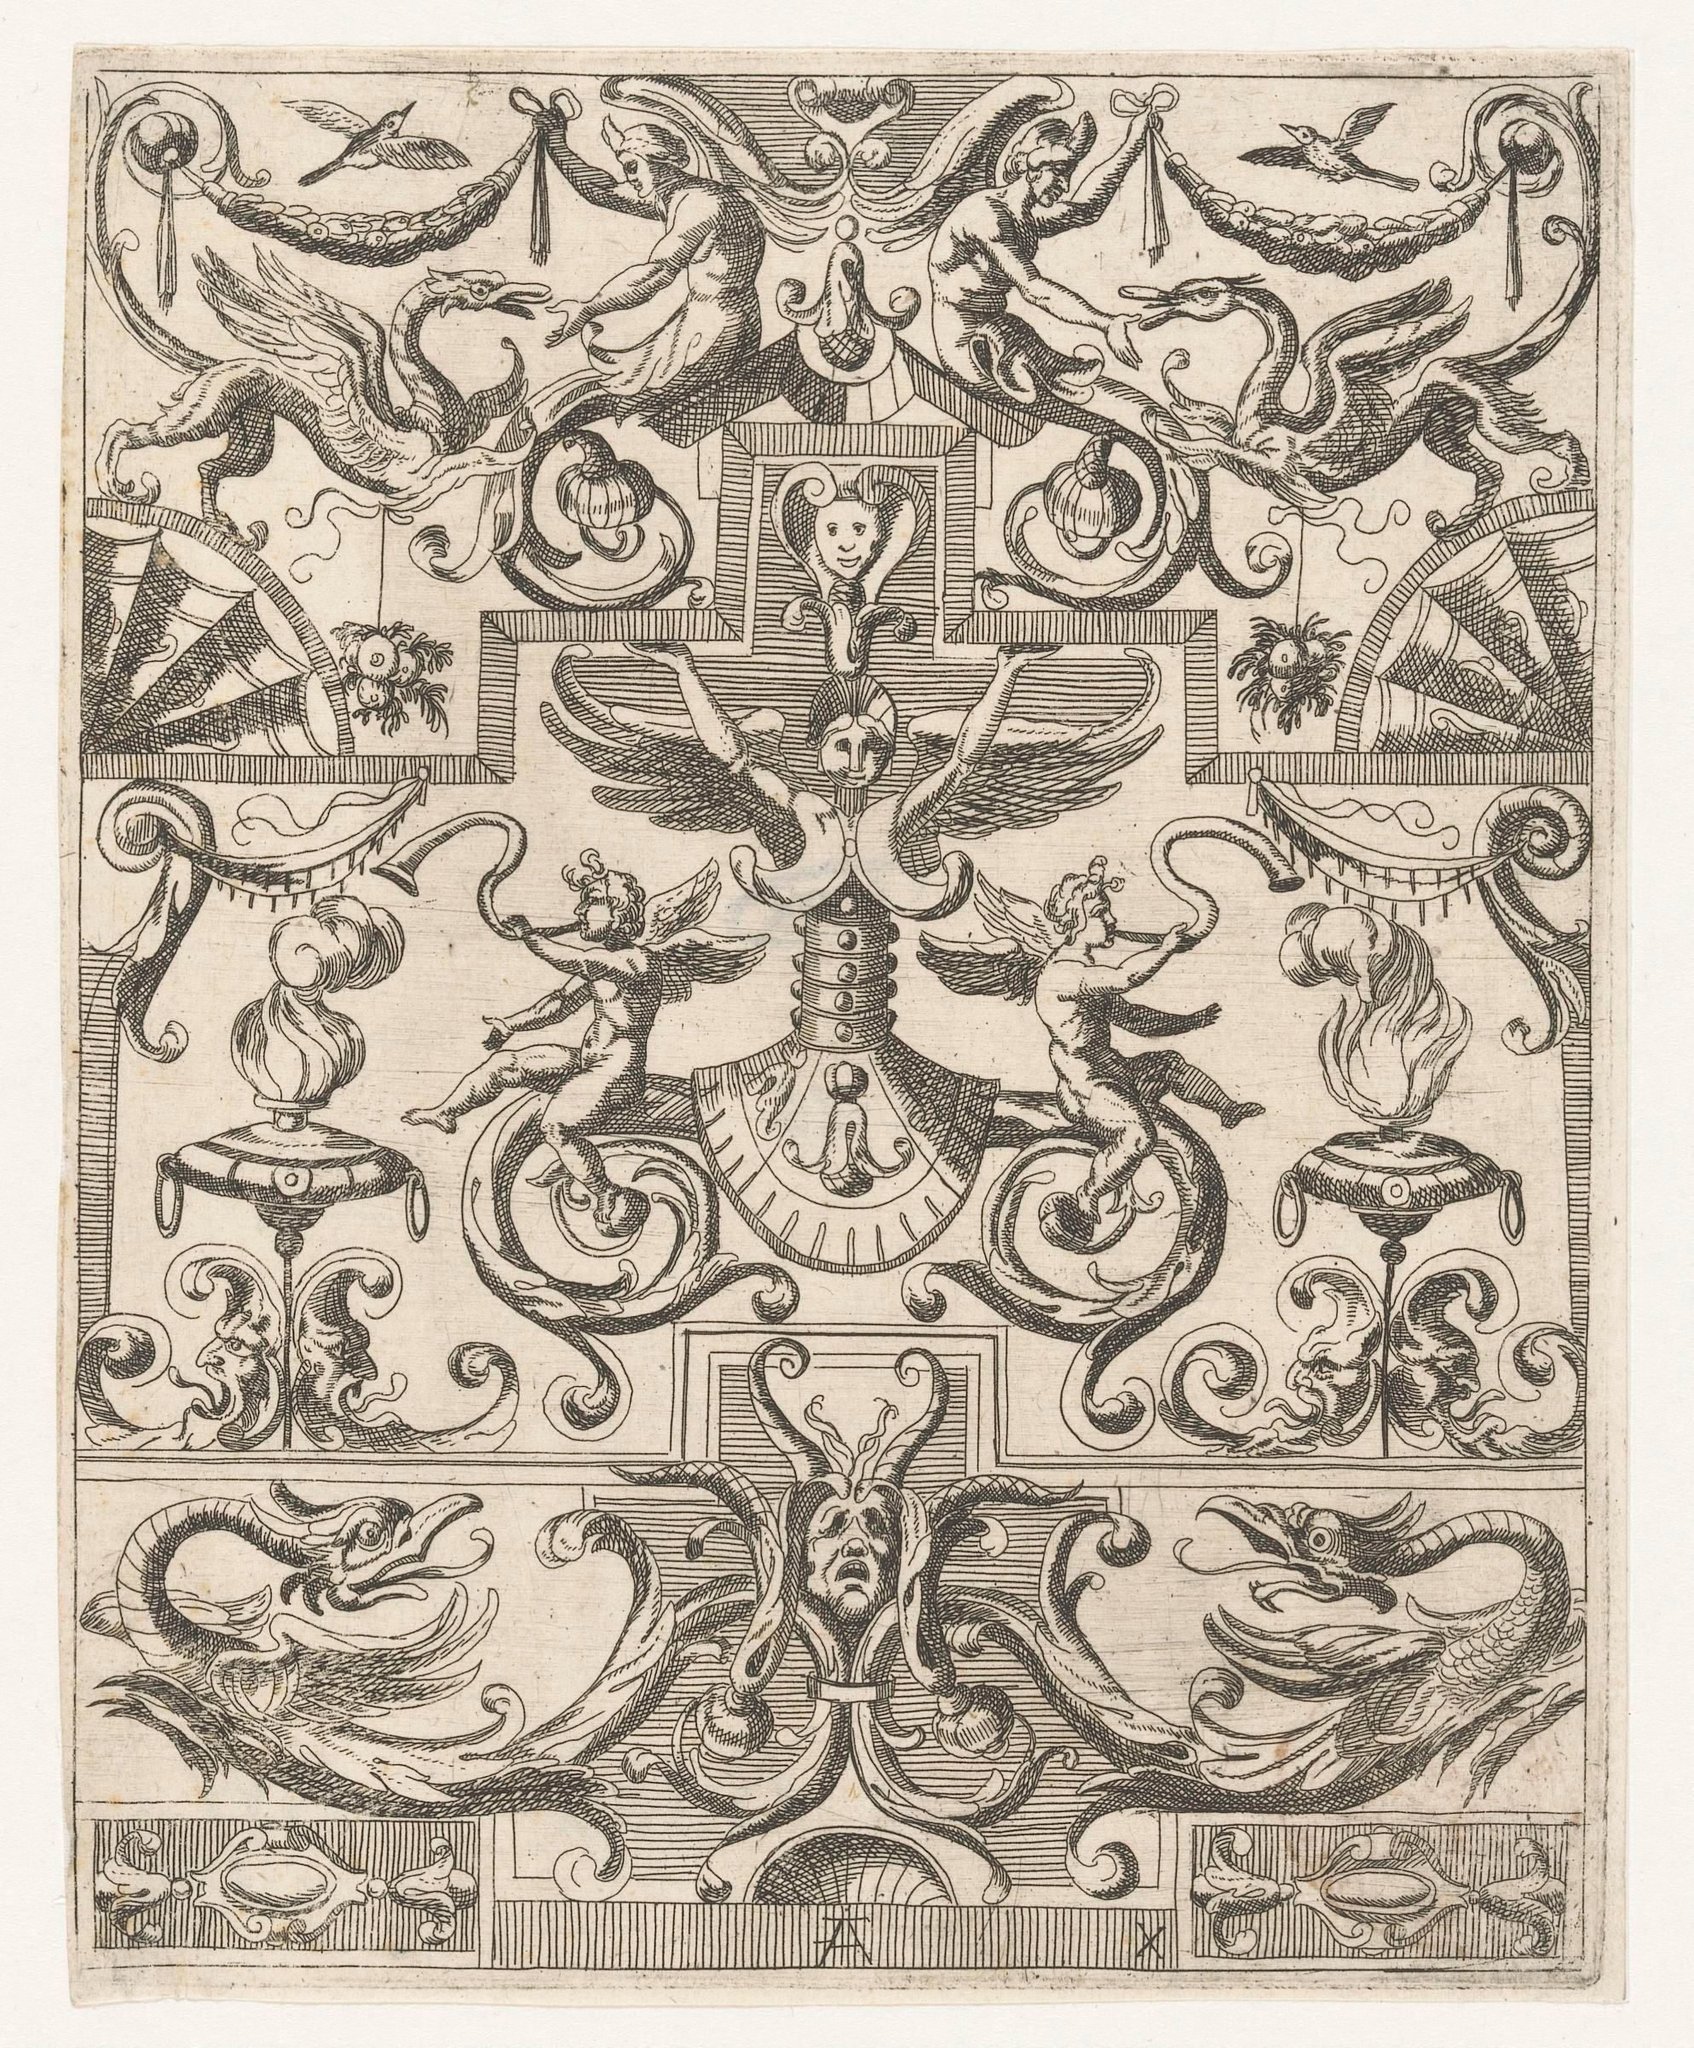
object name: ornament print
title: Esemplare del disegno in gratia dei principianti nell'arte della pitura et scultura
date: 1609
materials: paper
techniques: etching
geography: rome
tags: riding a horse, ass, or mule; rider, horseman, ornaments ~ art, open fire (in general)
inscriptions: collector's mark: Lugt 2228, collector's mark: Lugt 240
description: Deze prent maakt deel uit van een reeks van tien prenten met groteske ornamenten.